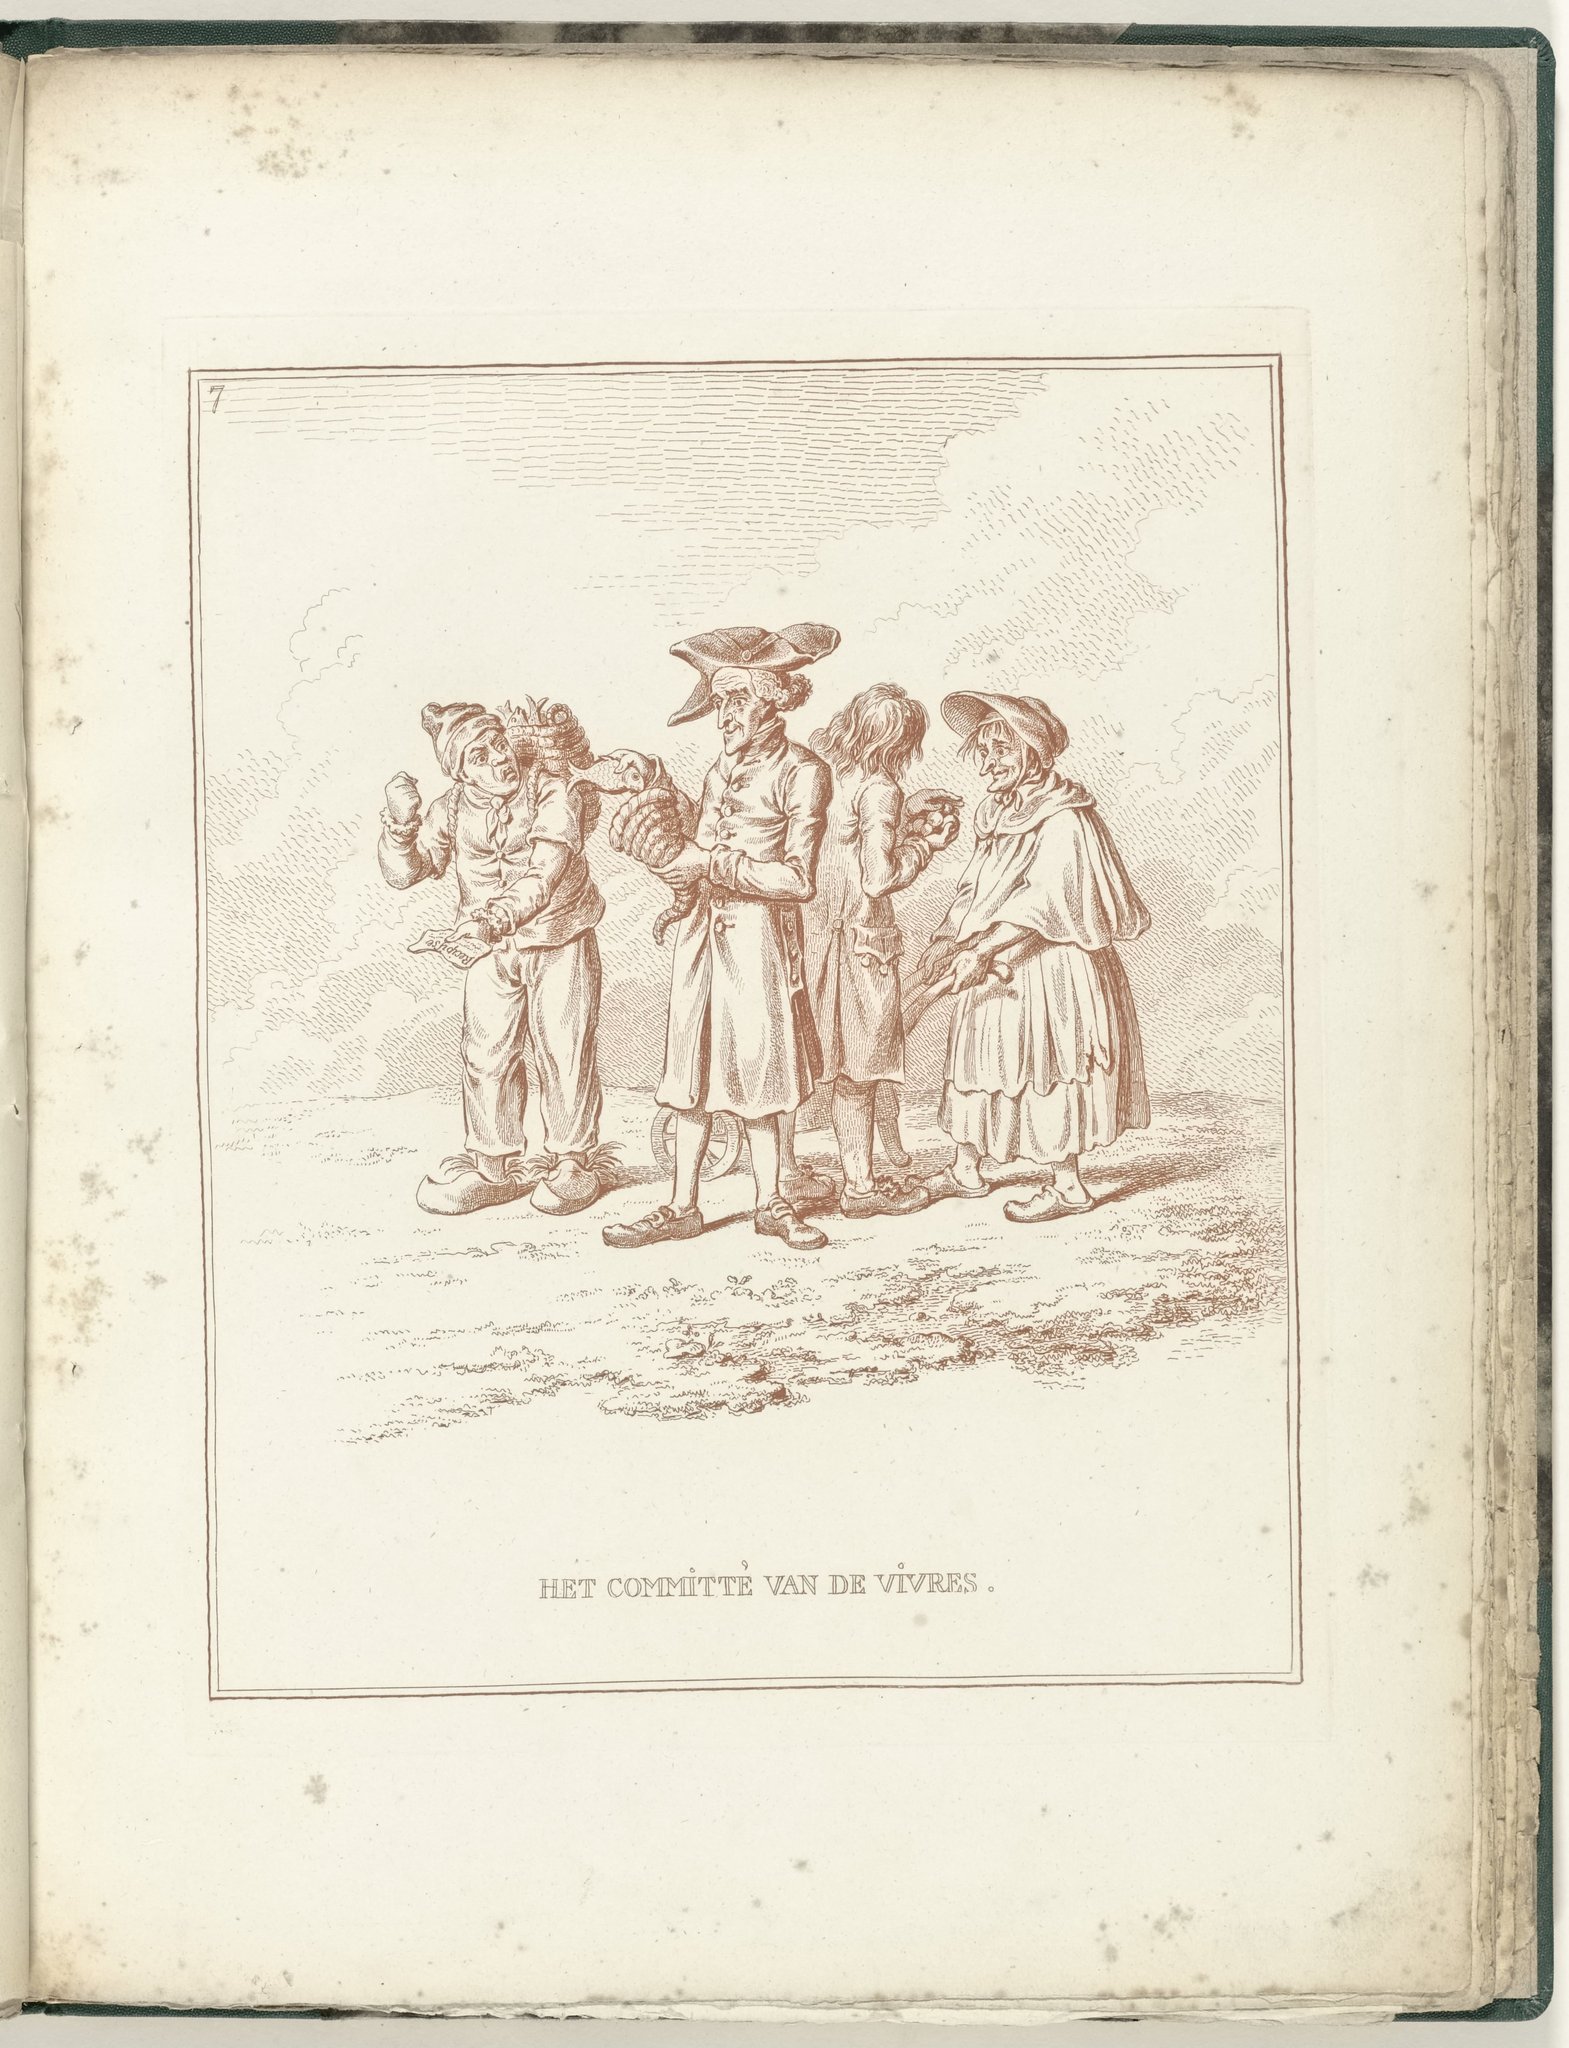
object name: print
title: Comité van de Vivres en Noodwendigheden, 1795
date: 1795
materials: paper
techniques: etching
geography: london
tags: seizure of goods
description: Onderdeel van een in boekvorm uitgegeven serie van twintig spotprenten op de Provisionele Representanten van het Volk van Holland en de Bataafse Republiek in het algemeen in het jaar 1795. De serietitel 'Hollandia Regenerata' staat vermeld op de titelprent. Elke prent gevolgd door een tekstblad met een Bijbelcitaat in het Nederlands, een verklaring in het Frans en het Bijbelcitaat in het Engels. Waarschijnlijk uitgegeven in Londen door William Humphrey in 1795.